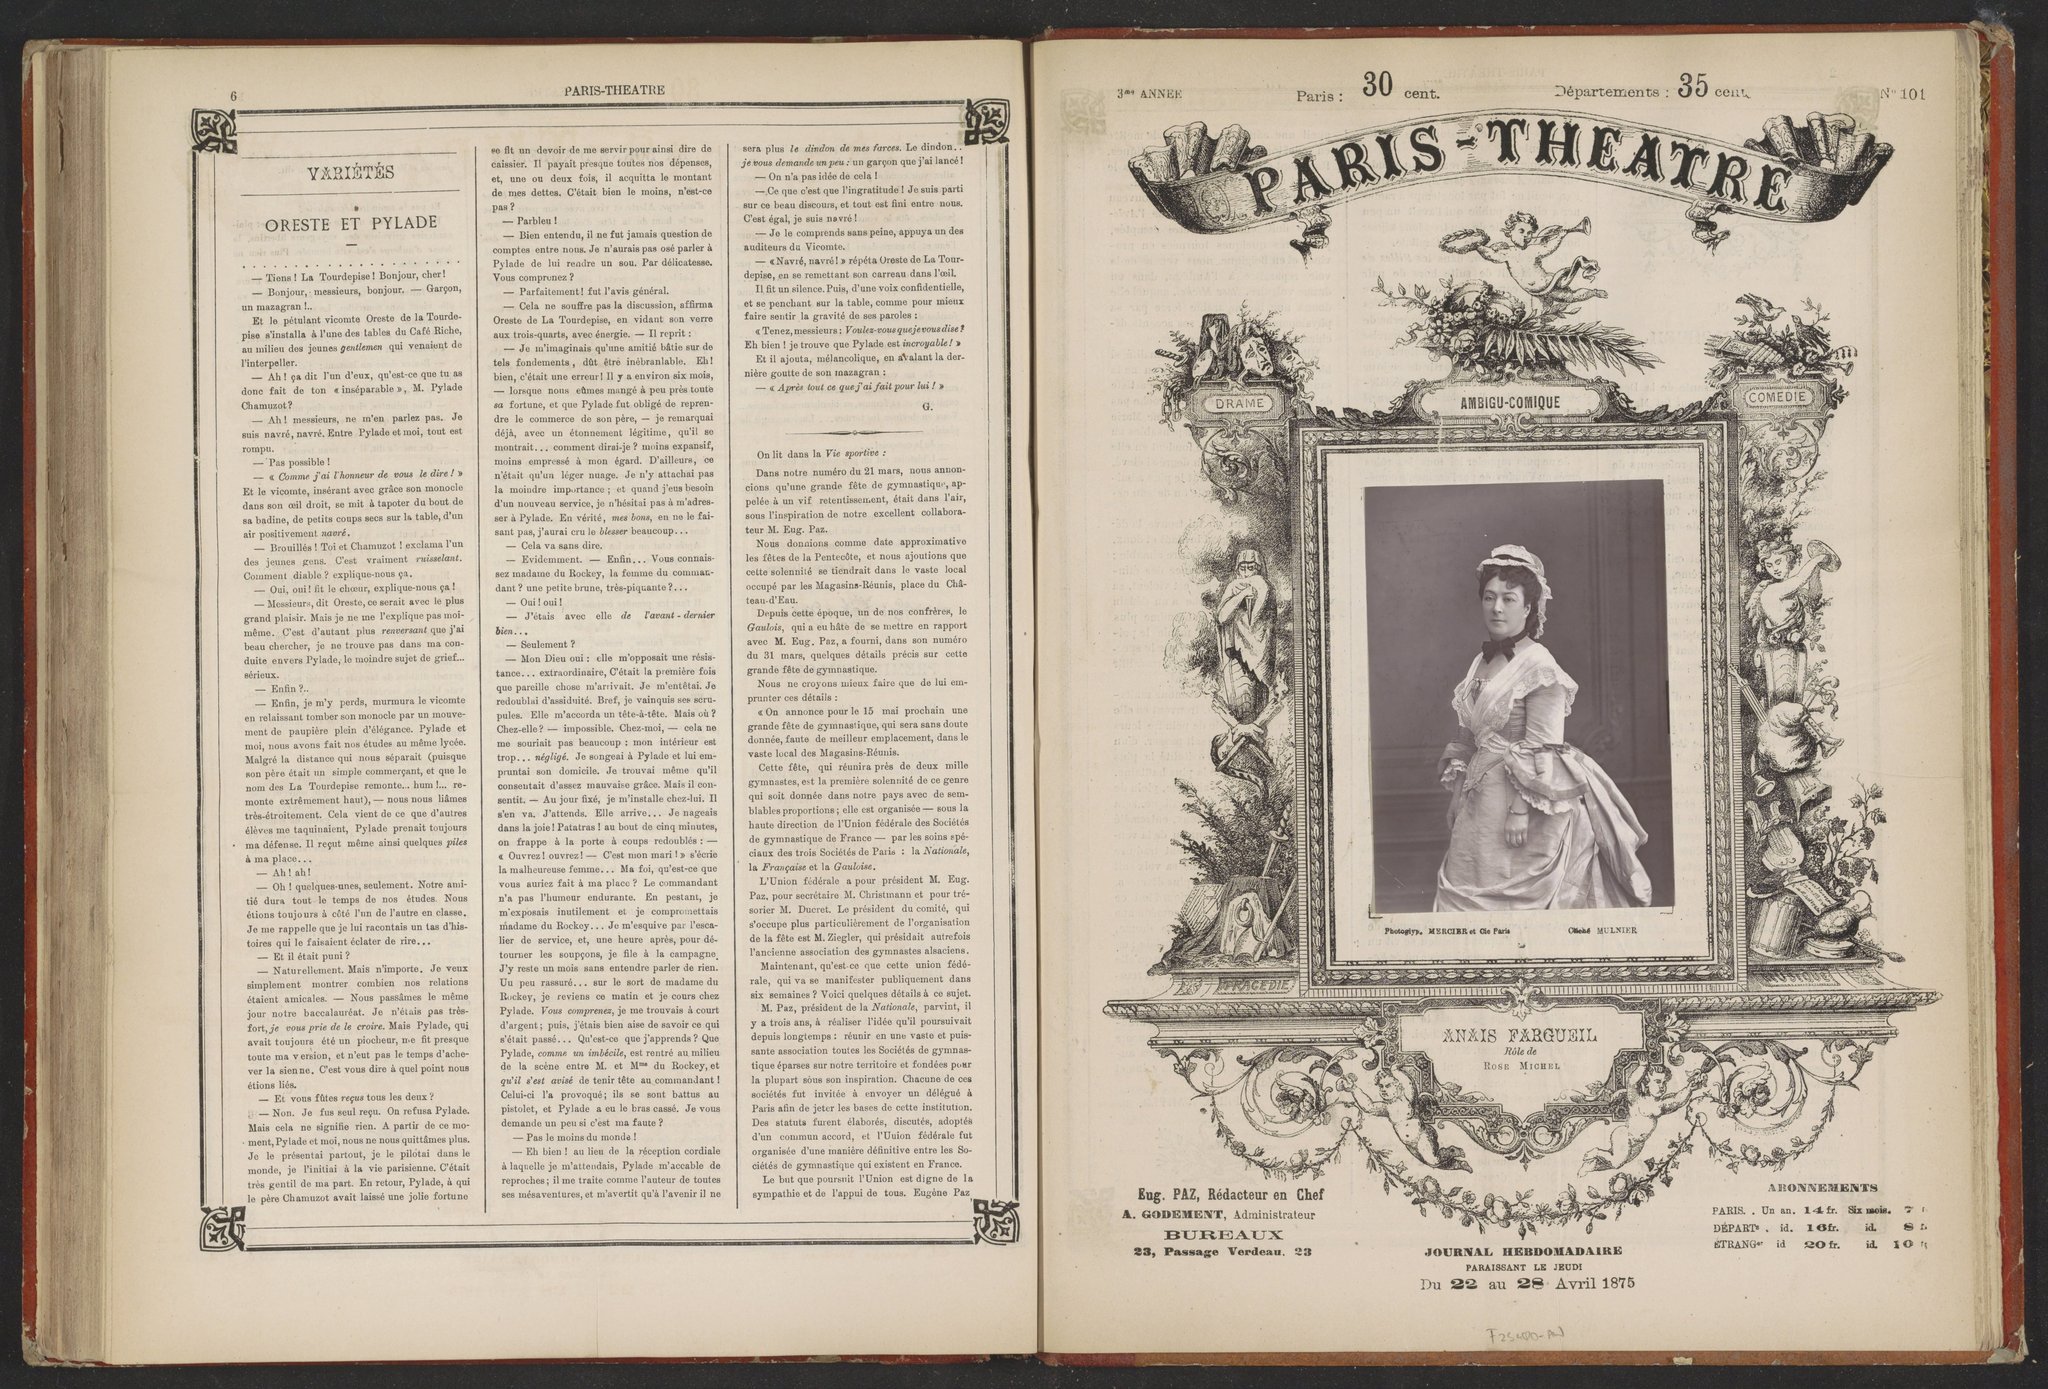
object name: page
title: Portret van Anaïs Fargueil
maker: mulnier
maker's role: fotograaf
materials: paper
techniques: woodburytype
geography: france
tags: portrait of actor, actress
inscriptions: number: ‘No 101’, inscription: ‘Journal hebdomadaire paraissant le jeudi Du 22 au 28 Avril 1875’